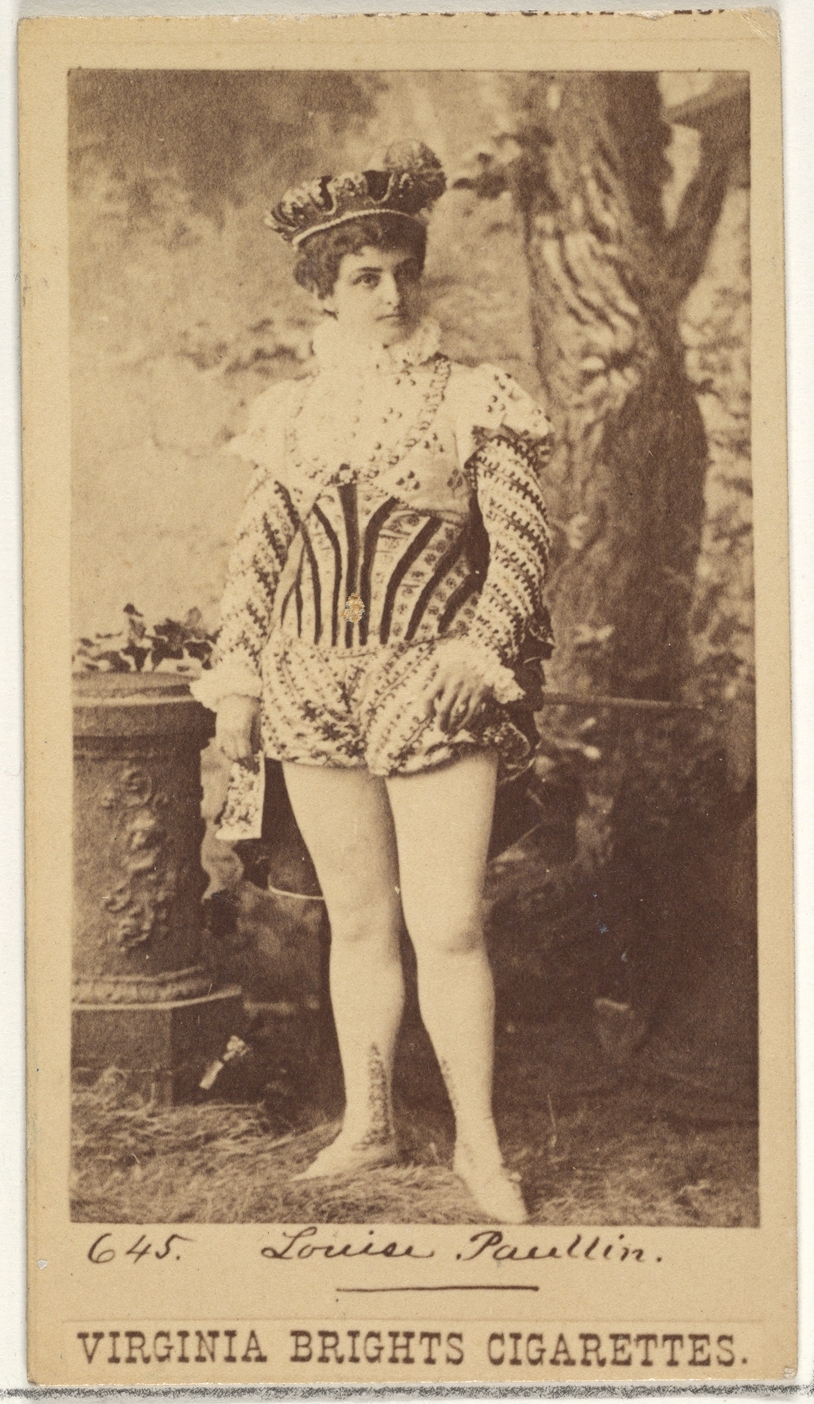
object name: photograph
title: Card 645, Louise Paullin, from the Actors and Actresses series (N45, Type 1) for Virginia Brights Cigarettes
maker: allen & ginter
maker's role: publisher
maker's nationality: american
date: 1888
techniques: albumen silver print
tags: portraits,women,actresses